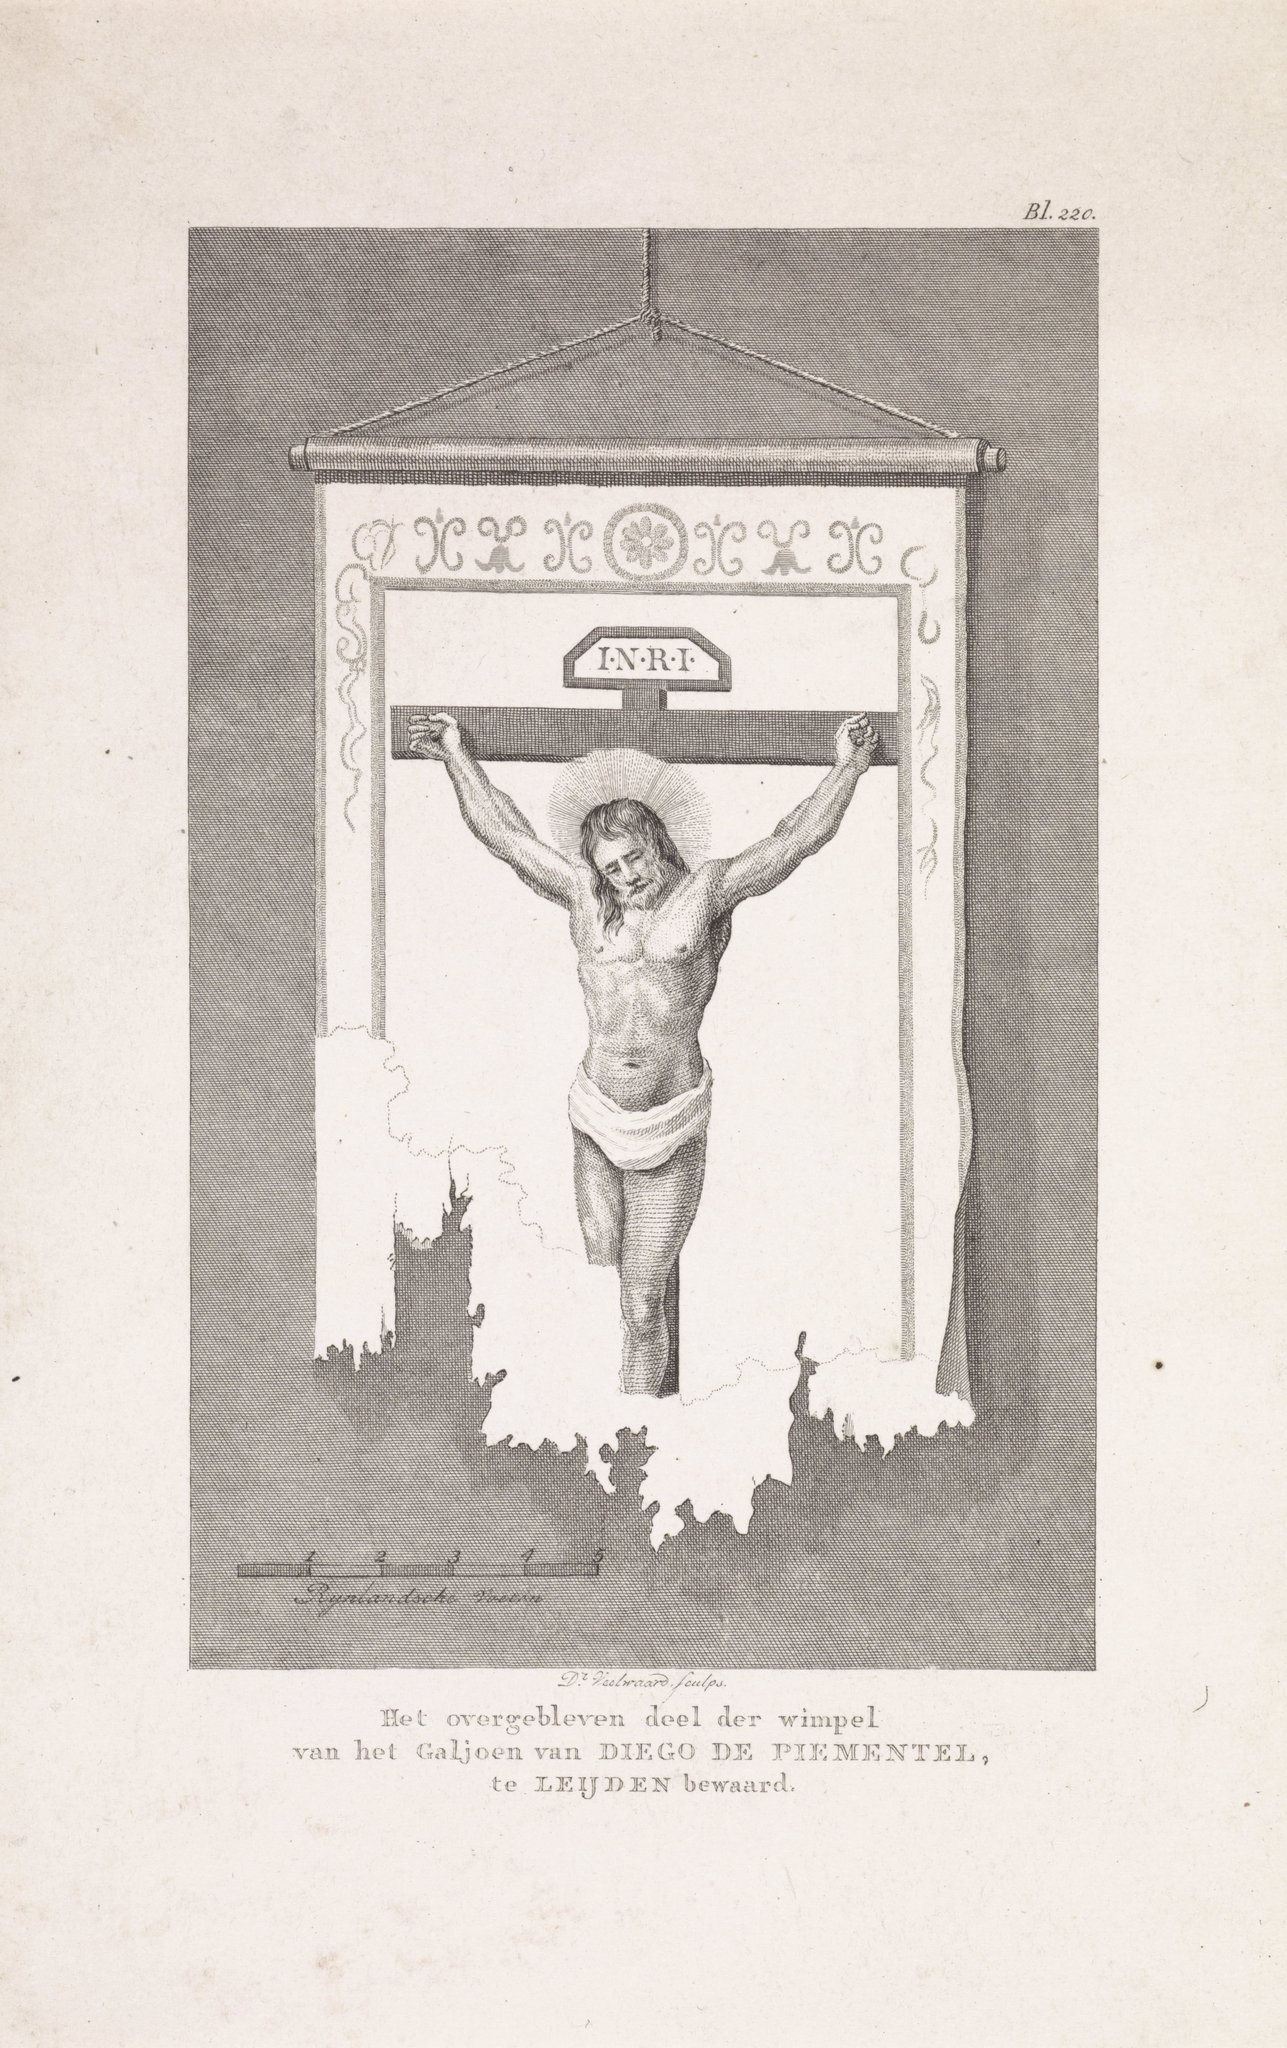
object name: print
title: Het overgebleven deel der wimpel van het Galjoen van Diego de Piementel, te Leijden bewaard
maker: daniël veelwaard (i)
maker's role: print maker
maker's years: 1766-1851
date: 1776-1851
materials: paper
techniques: engraving, etching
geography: amsterdam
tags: specific types of crucified christ (in non-narrative context), banner, standard (as symbol of the state, etc.)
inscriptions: collector's mark: Lugt 2228